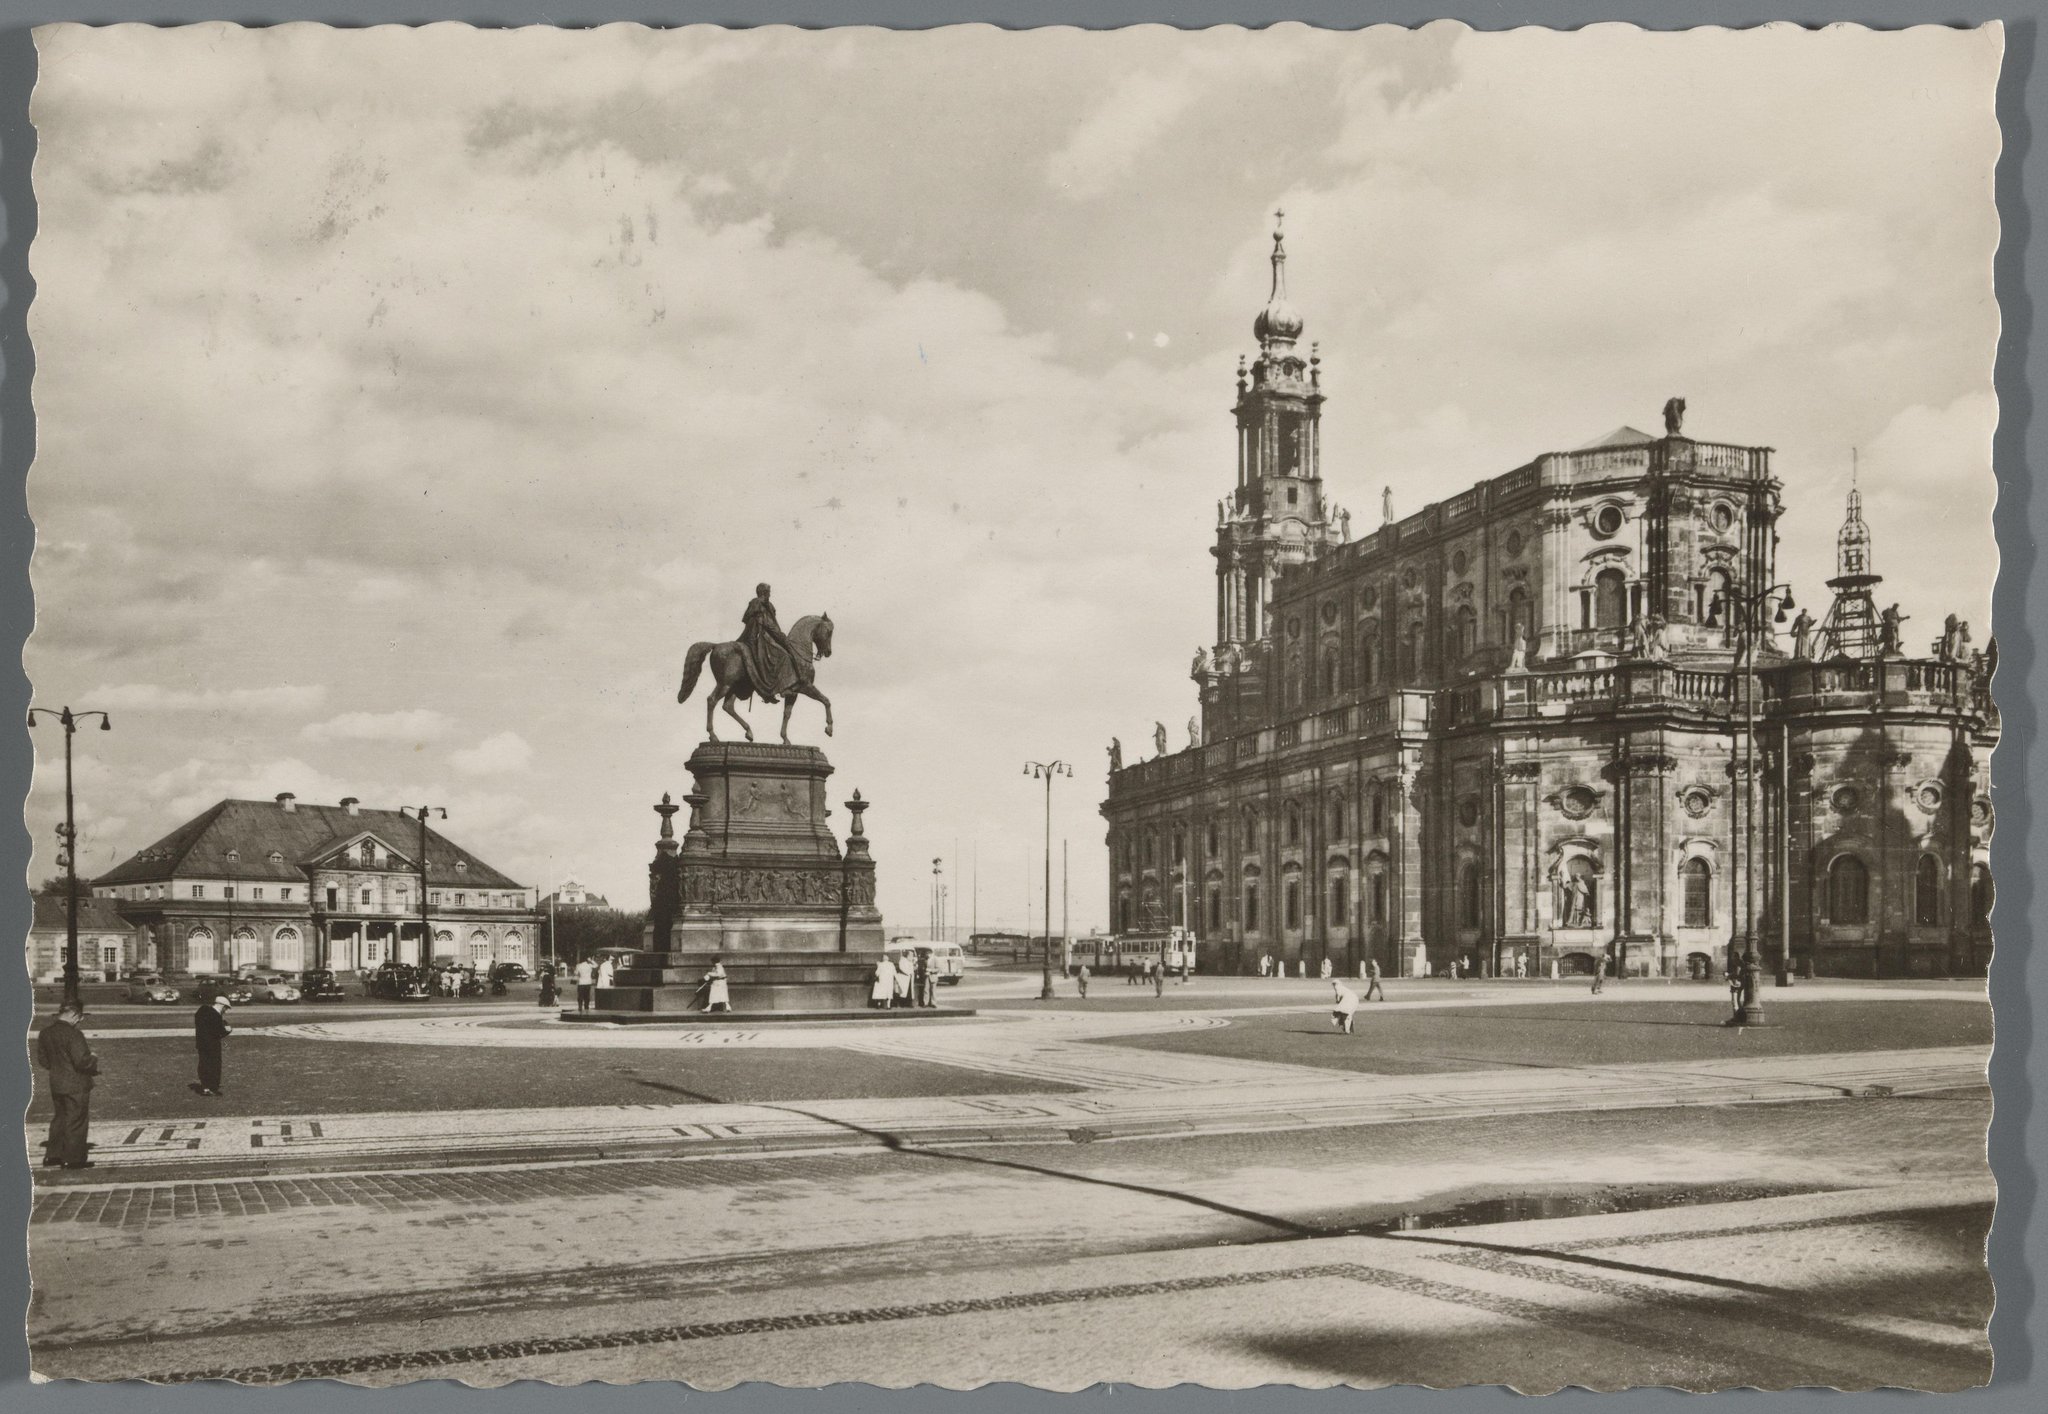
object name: postcard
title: Dresden. Theaterplattz mit "Italen. Dörfchen"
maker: Anonymous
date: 1920-1950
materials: photographic support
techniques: gelatin silver print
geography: dresden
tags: dresden